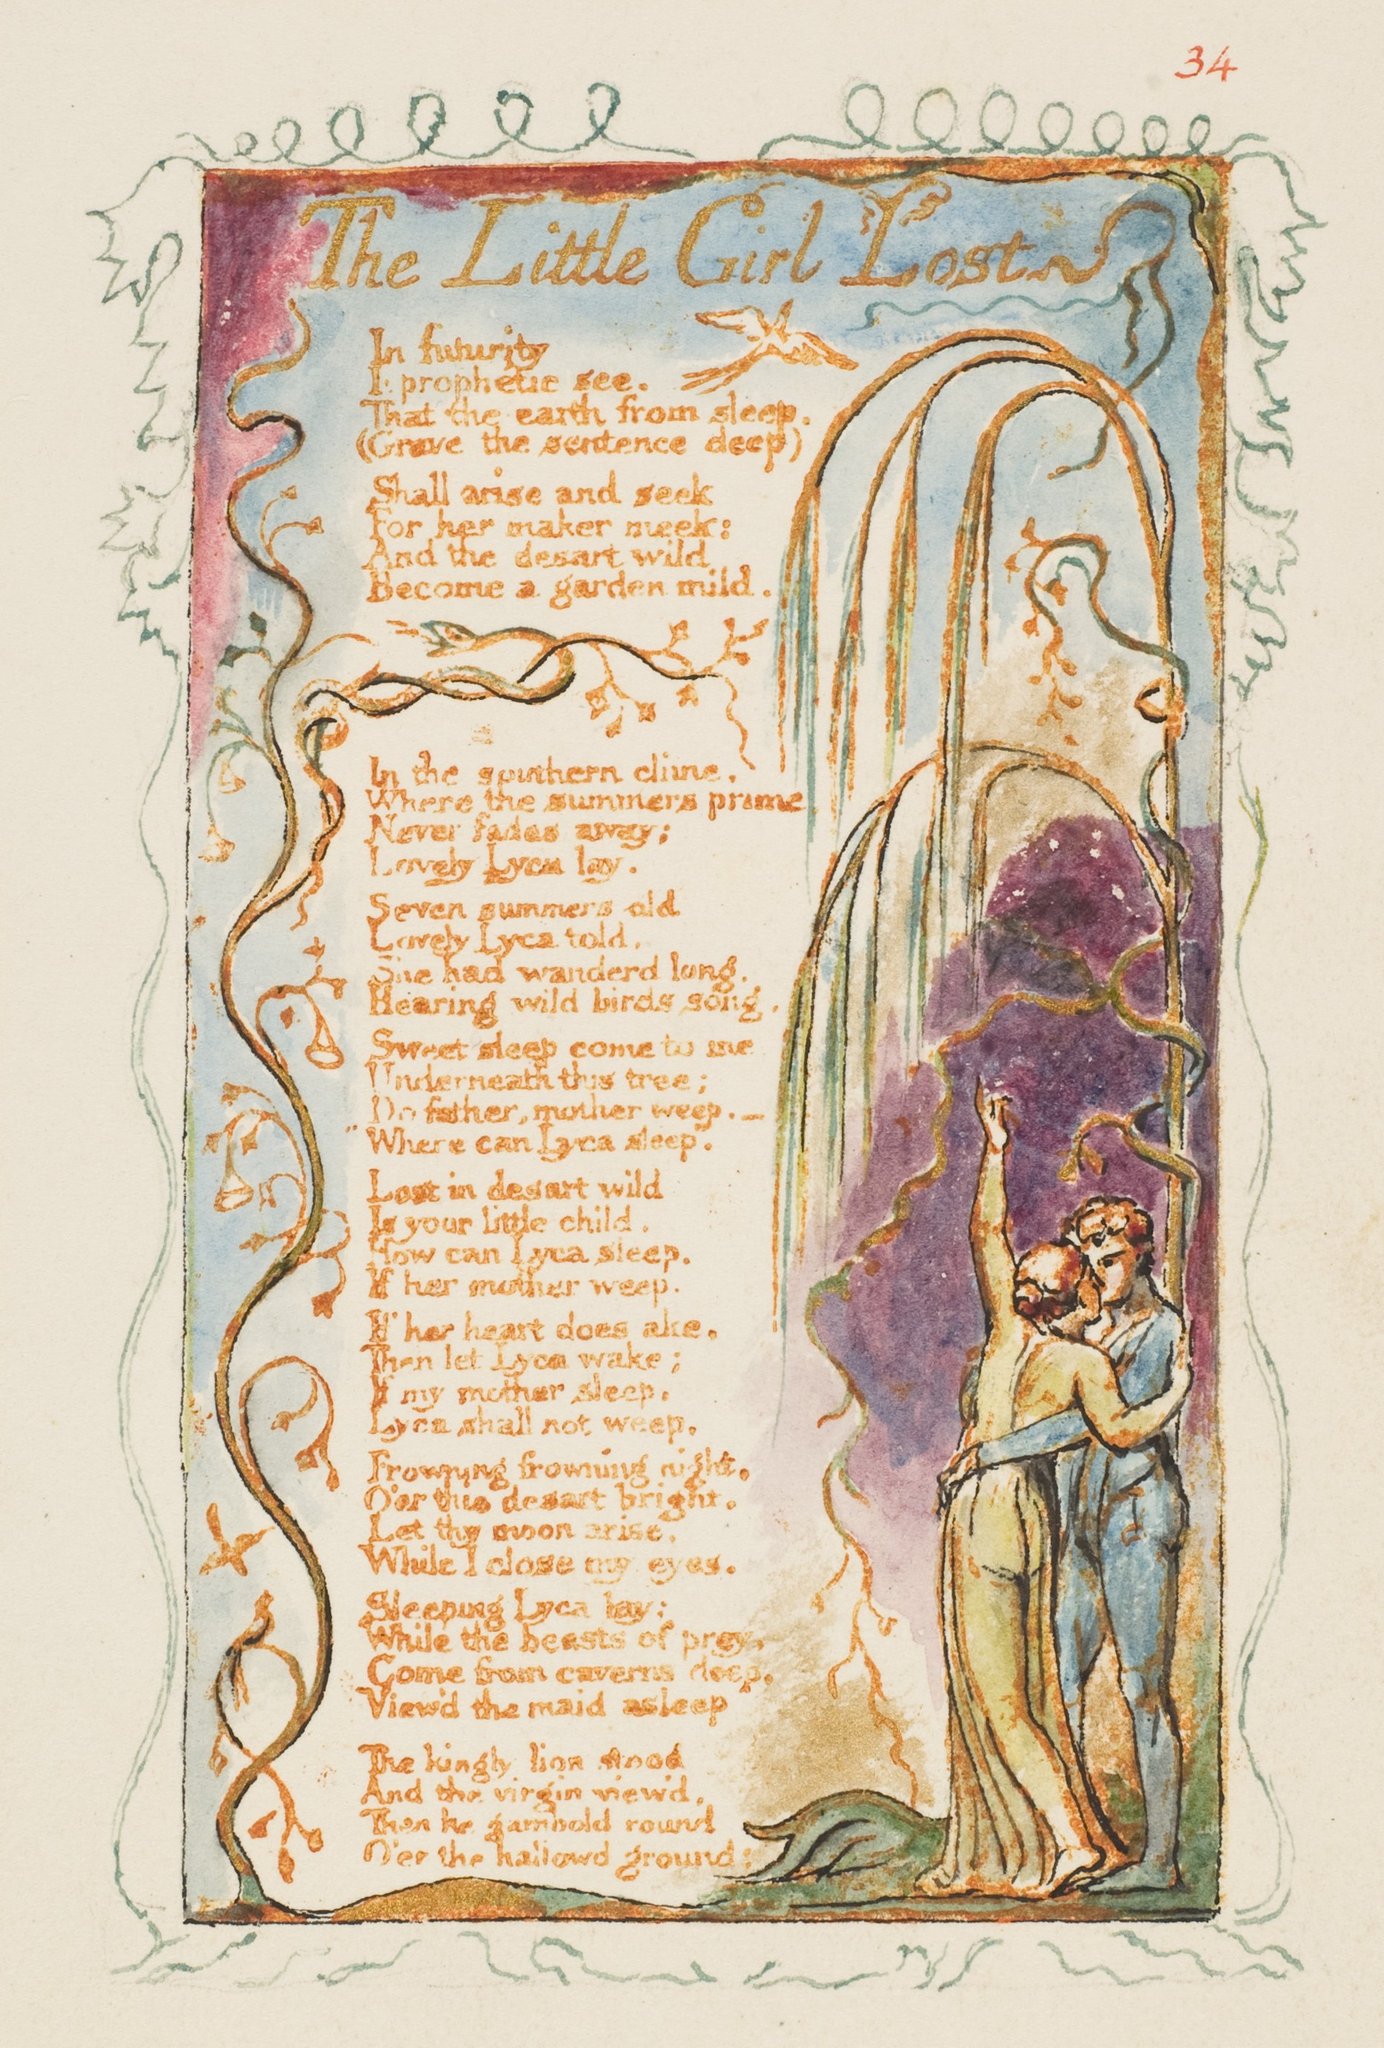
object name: print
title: Songs of Experience: The Little Girl Lost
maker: william blake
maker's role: artist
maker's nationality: british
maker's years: 1757-1827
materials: gold, ink, shell, watercolor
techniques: etching, hand coloring, printing, relief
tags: birds,poetry,couples,men,women